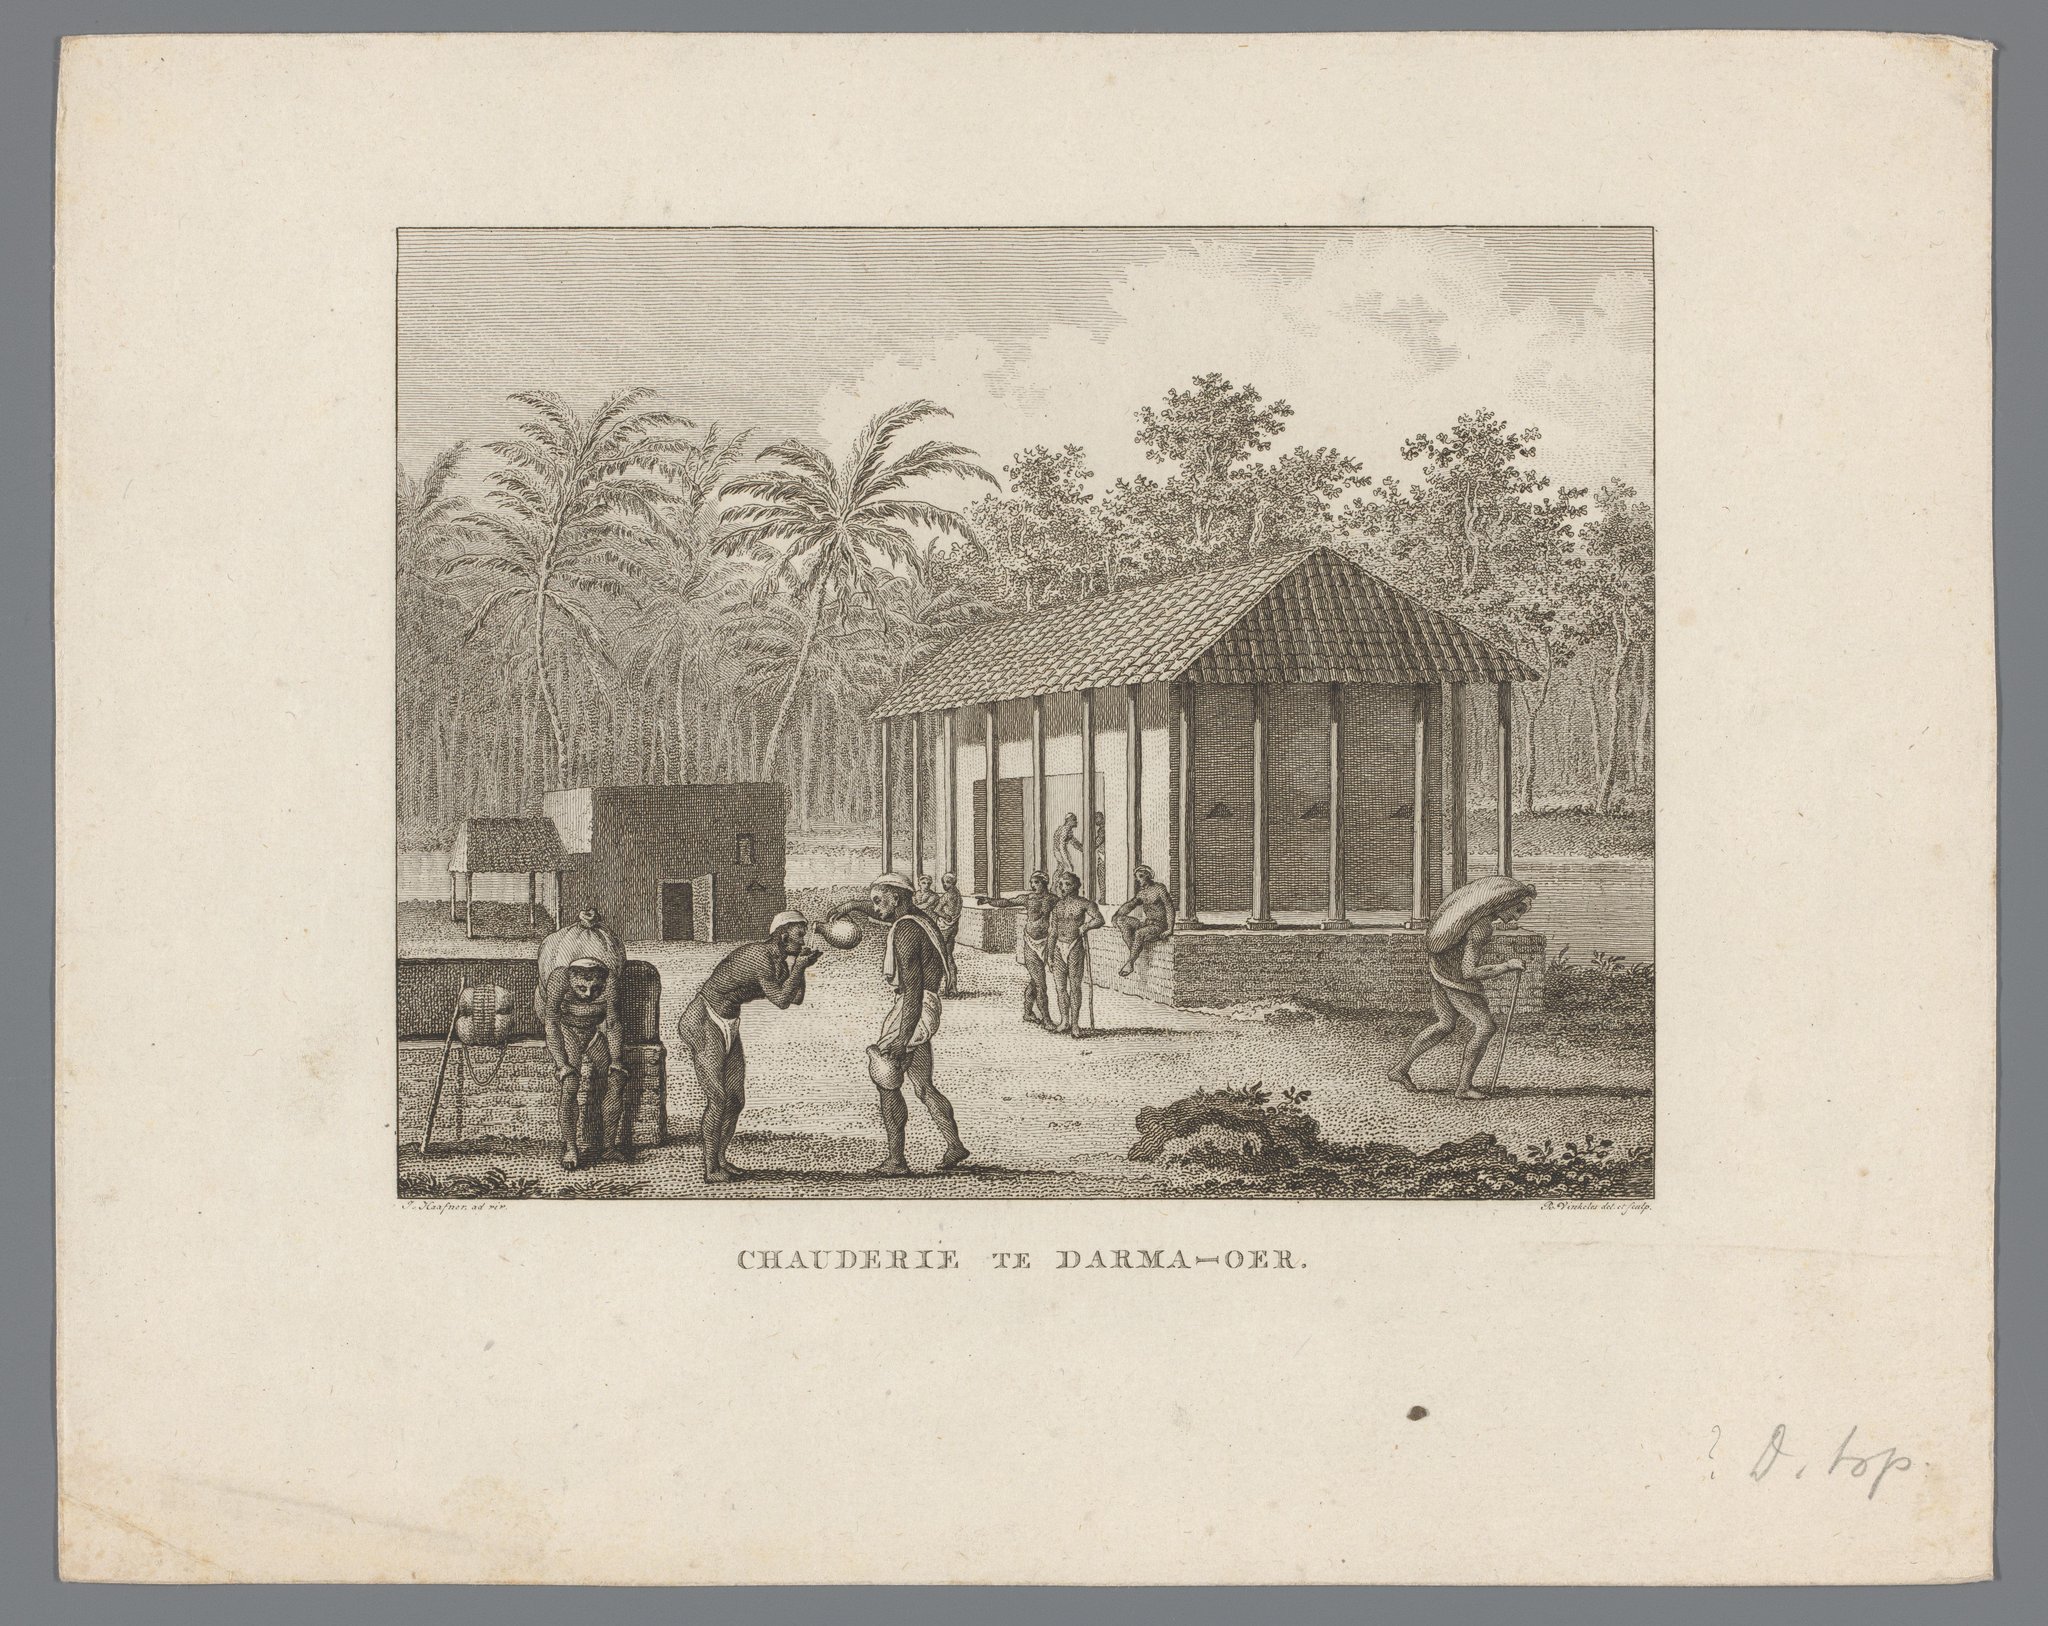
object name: book illustration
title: Chauderie te Darma-Oer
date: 1808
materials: paper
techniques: engraving, etching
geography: amsterdam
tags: inn, coffee-house, public house, etc.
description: Voor een klein gebouw schenkt een monnik drank in de handen van een reiziger. Enkele andere reizigers zijn ook afgebeeld, evenals een bijgebouw. Op de achtergrond een bos met onder andere palmbomen. Darma-Oer is een niet geïdentificeerde plaats in de Indiase provincie Andhra Pradesh.